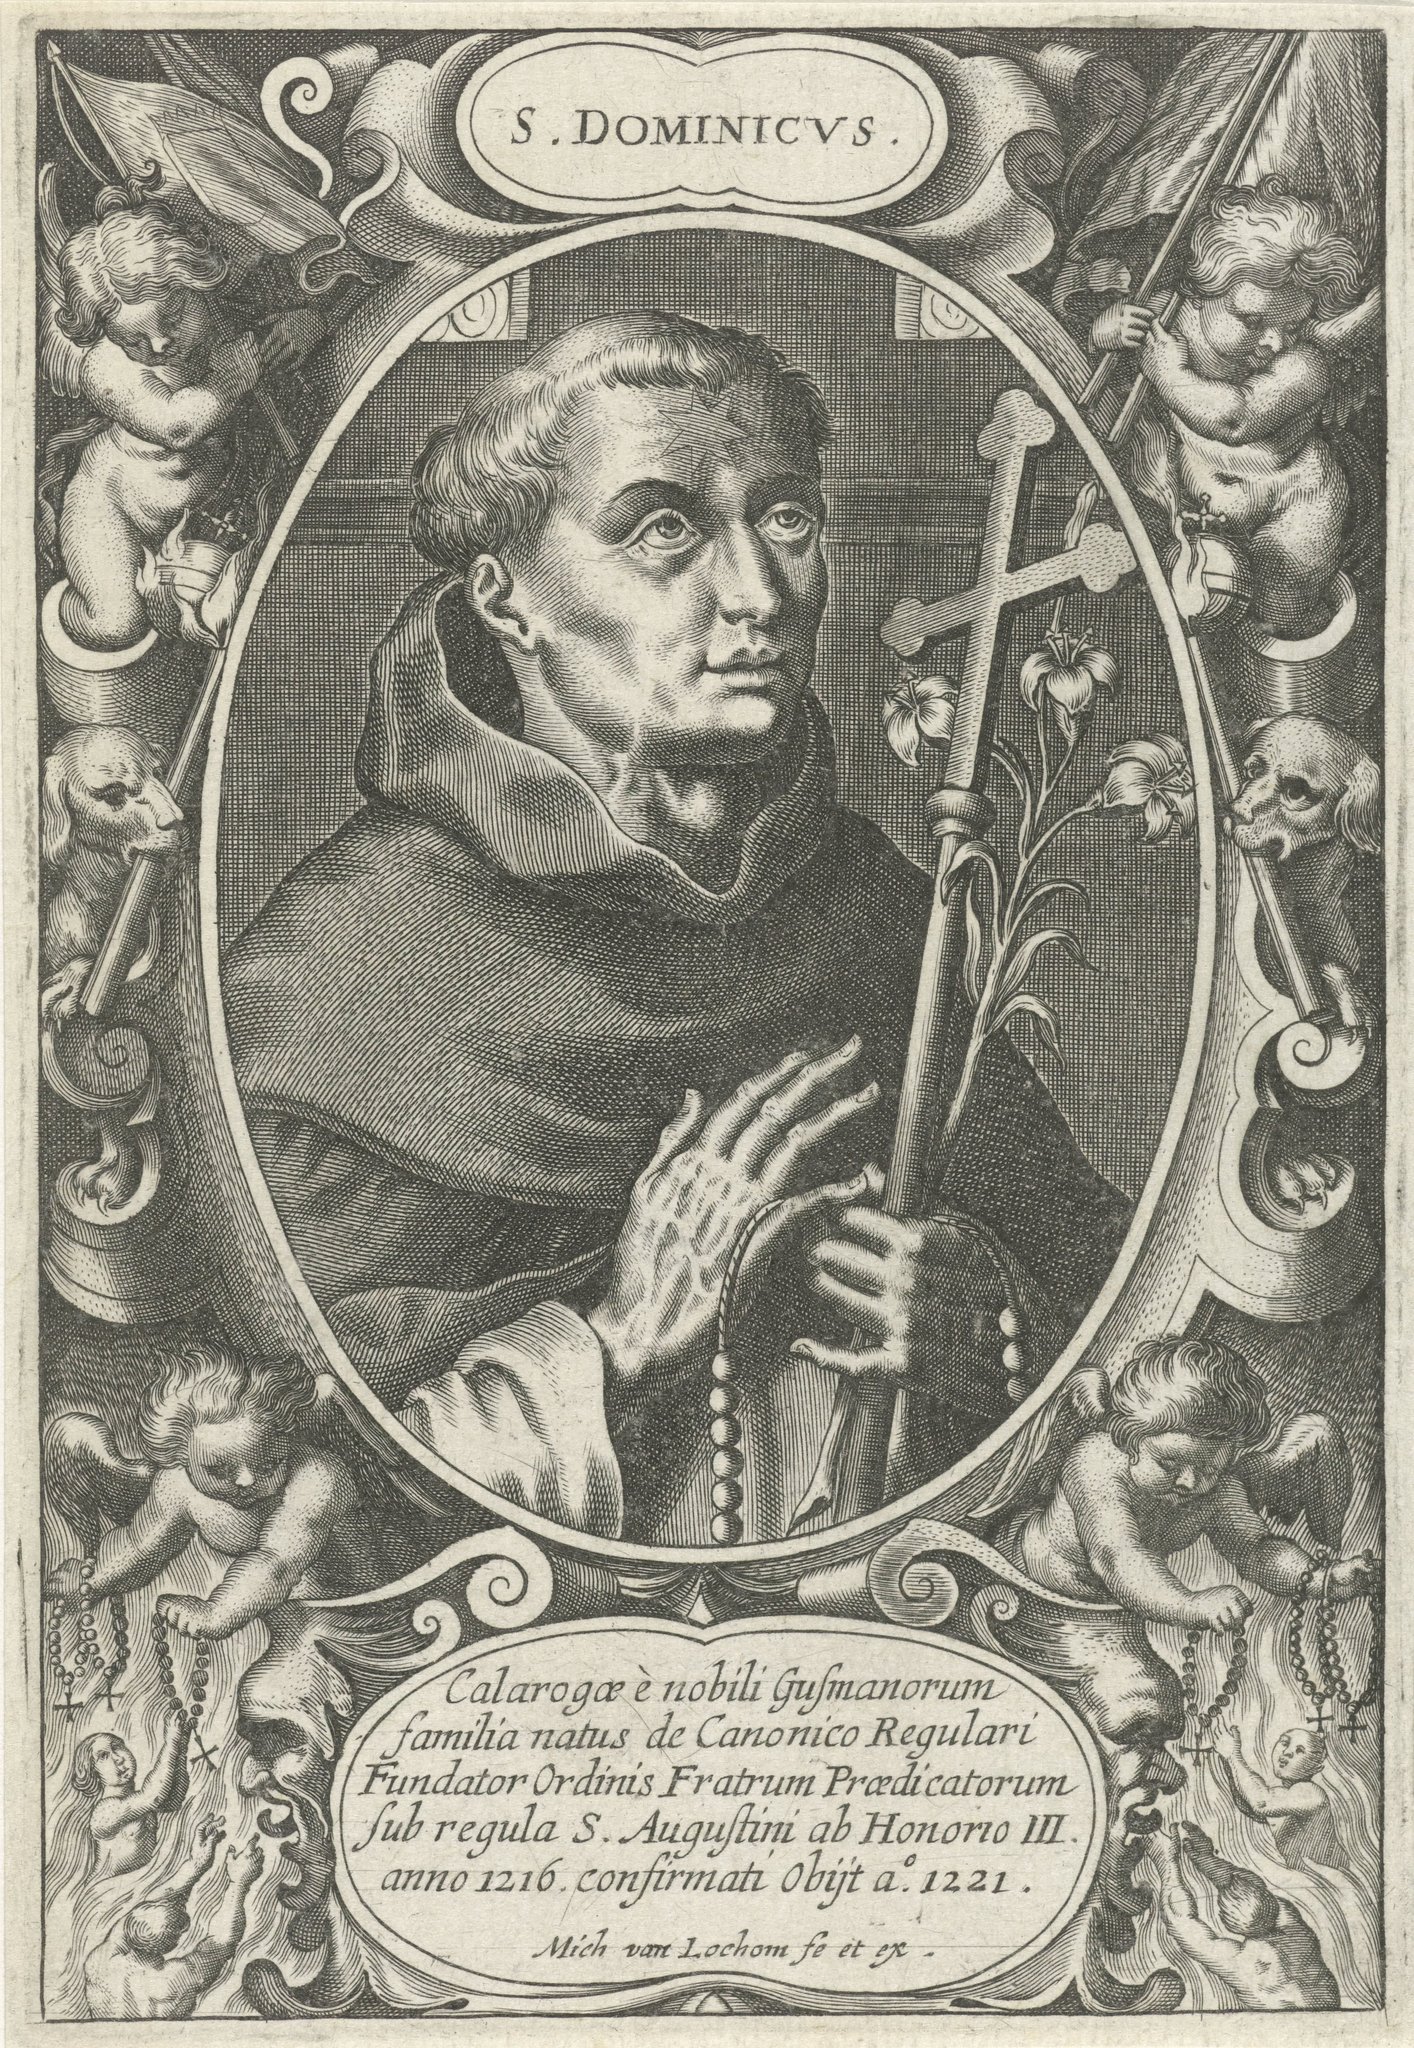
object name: print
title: Heiligen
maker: michel van lochom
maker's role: print maker, publisher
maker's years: 1601-1647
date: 1611-1647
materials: paper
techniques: engraving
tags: dominic(us) guzman of calerueja, founder of the order of preachers (or dominican (black) friars; possible attributes: book, dog with flaming torch, lily, loaf of bread, rosary, star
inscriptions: collector's mark: Lugt 2228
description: Portret van de heilige Dominicus, stichter van de Dominicanen.